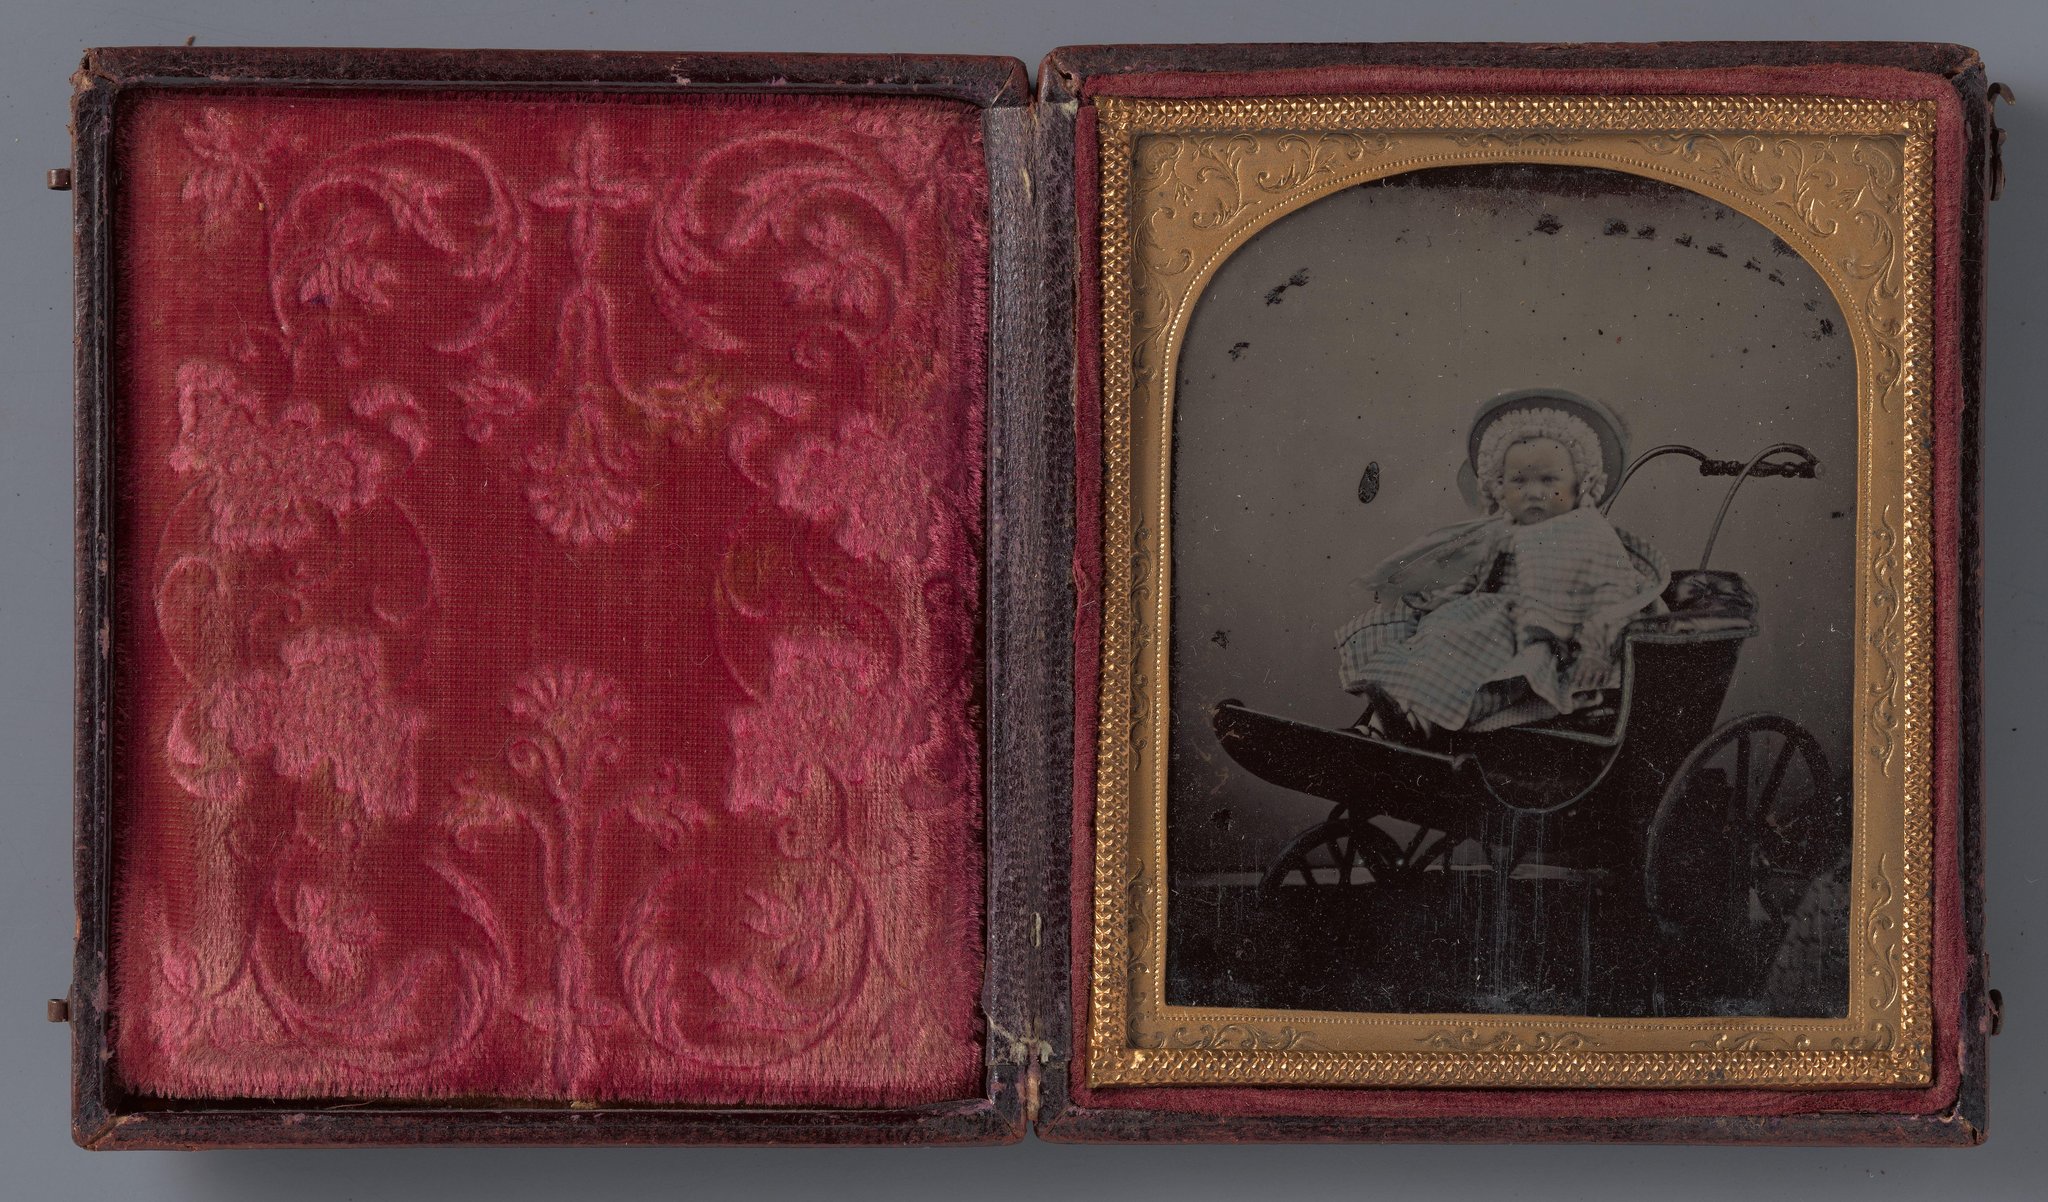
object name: photograph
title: Portret van een onbekende baby in kinderwagen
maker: Anonymous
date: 1855-1870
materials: glass, leather, metal, velvet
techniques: ambrotype, hand coloring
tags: baby-carriage, pram, perambulator, historical persons, infant, baby